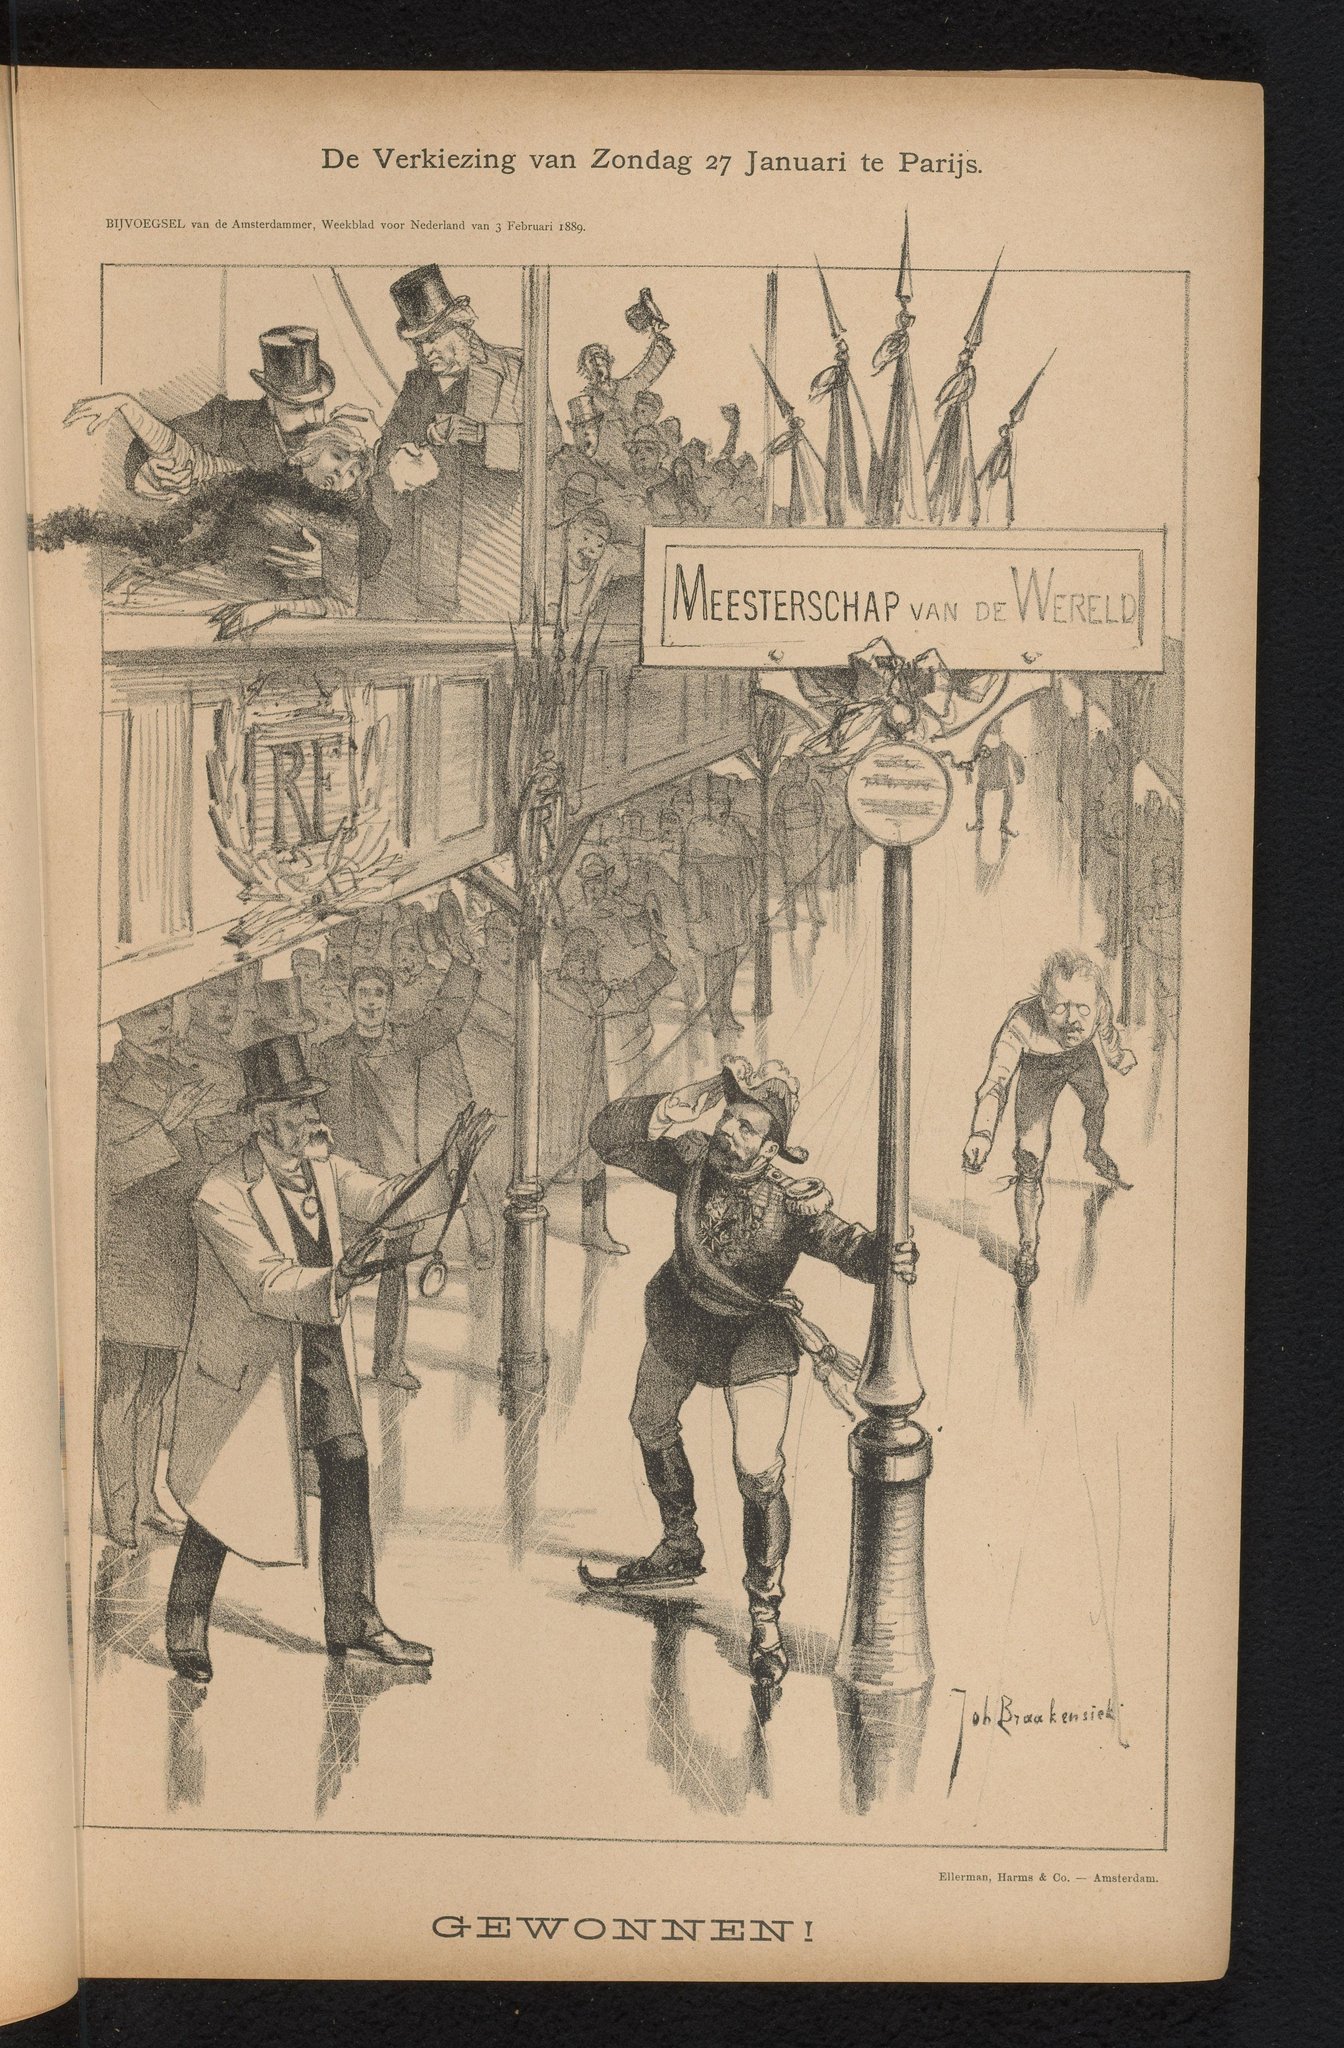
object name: cartoon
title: De Verkiezing van Zondag 27 Januari te Parijs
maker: johan braakensiek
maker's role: draughtsman, print maker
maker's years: 1858-1940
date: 1889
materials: paper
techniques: lithograph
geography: netherlands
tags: voting, election, fainting, swooning, skates (winter sports), personifications of countries, nations, states, districts, etc. (+ nation; national), political caricatures and satires, paris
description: Vervolg van de schaatswedstrijd met als bestemming het 'Meesterschap van de Wereld'. De Franse generaal Georges Boulanger bereikt als eerste de eindstreep en krijgt een medaille aangereikt. Naar aanleiding van zijn winst in de verkiezingen van 27 januari waar hij als afgevaardigde voor Parijs in de Kamer van Afgevaardigden wordt gekozen. Boven valt de Franse maagd Marianne flauw.